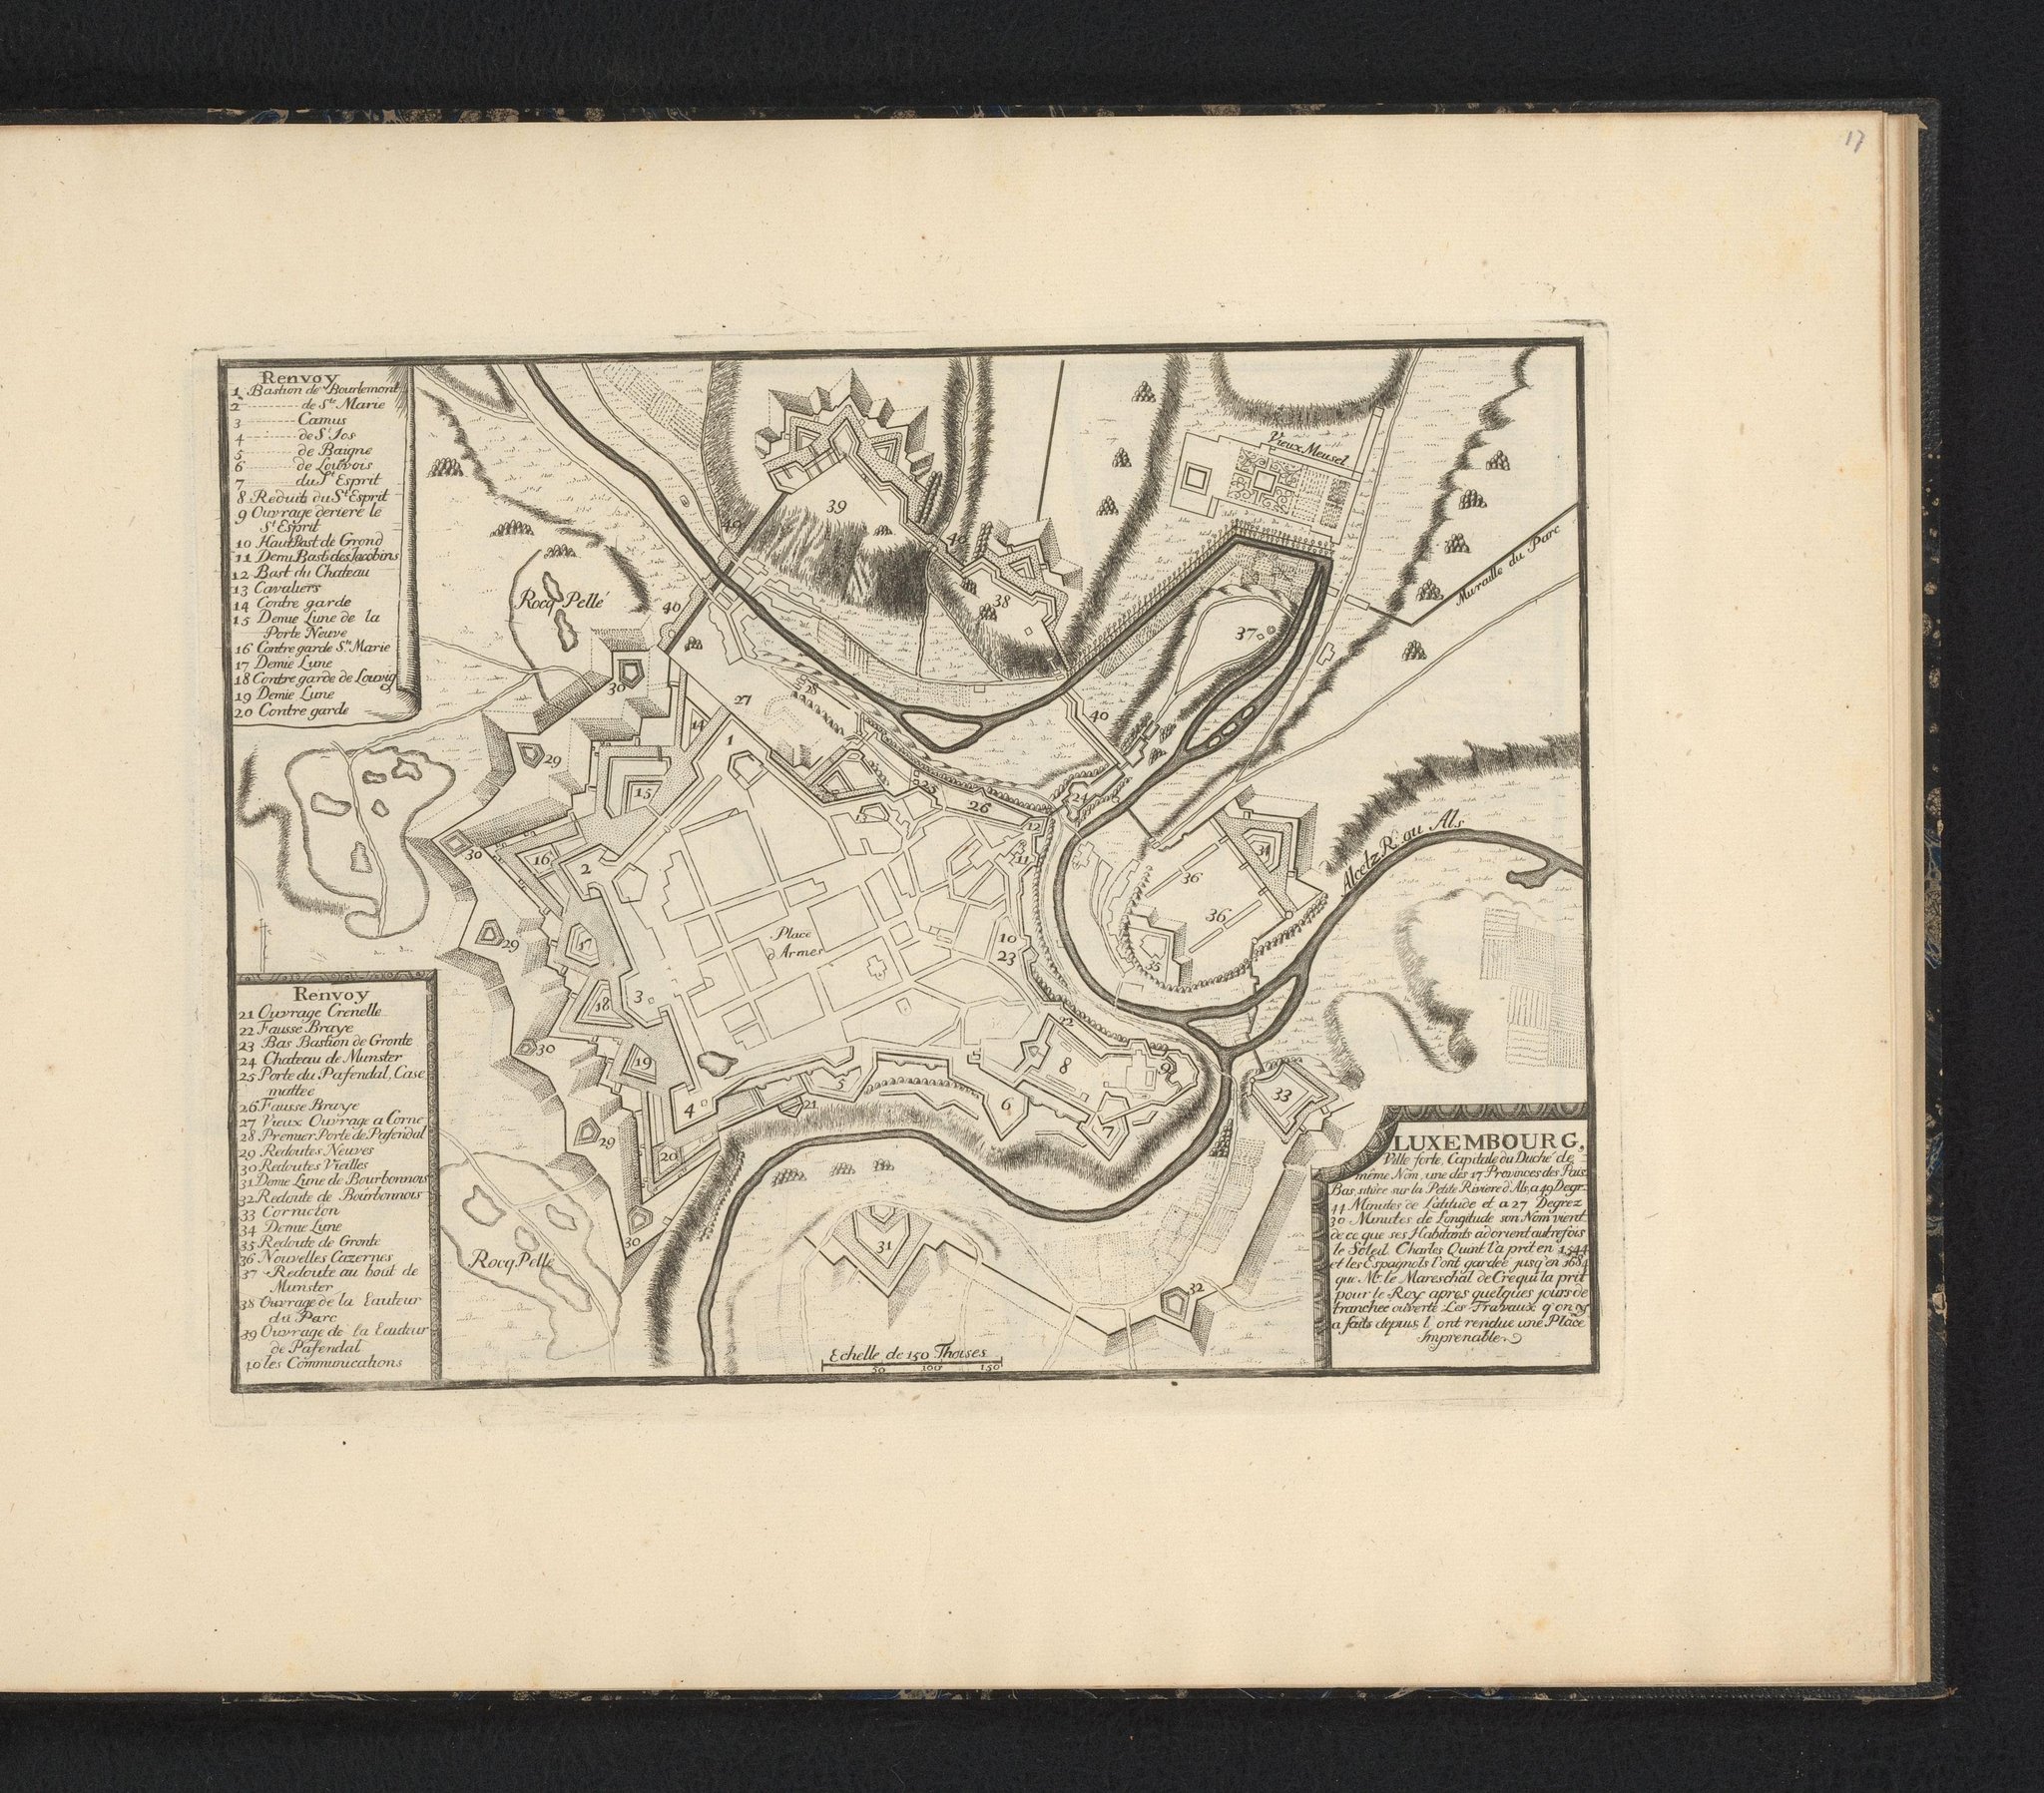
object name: map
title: Luxembourg. Ville Forte, Capitale du Duché de même nom (...)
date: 1693-1696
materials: paper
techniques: etching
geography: france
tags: fortress, maps of cities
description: Plattegrond van de versterkingen om de stad Luxemburg. Maakt deel uit van het eerste deel van het prentwerk: Le Theatre de la Guerre, dans les Pays-Bas, uitgegeven in 1696. Dit deel bevat 25 platen met plannen (afkomstig van Sébastien Le Prestre, Seigneur de Vauban) van vermaarde sterke steden en vestingen in de Negenjarige Oorlog in de Nederlanden. Titel en opschriften in het Frans.